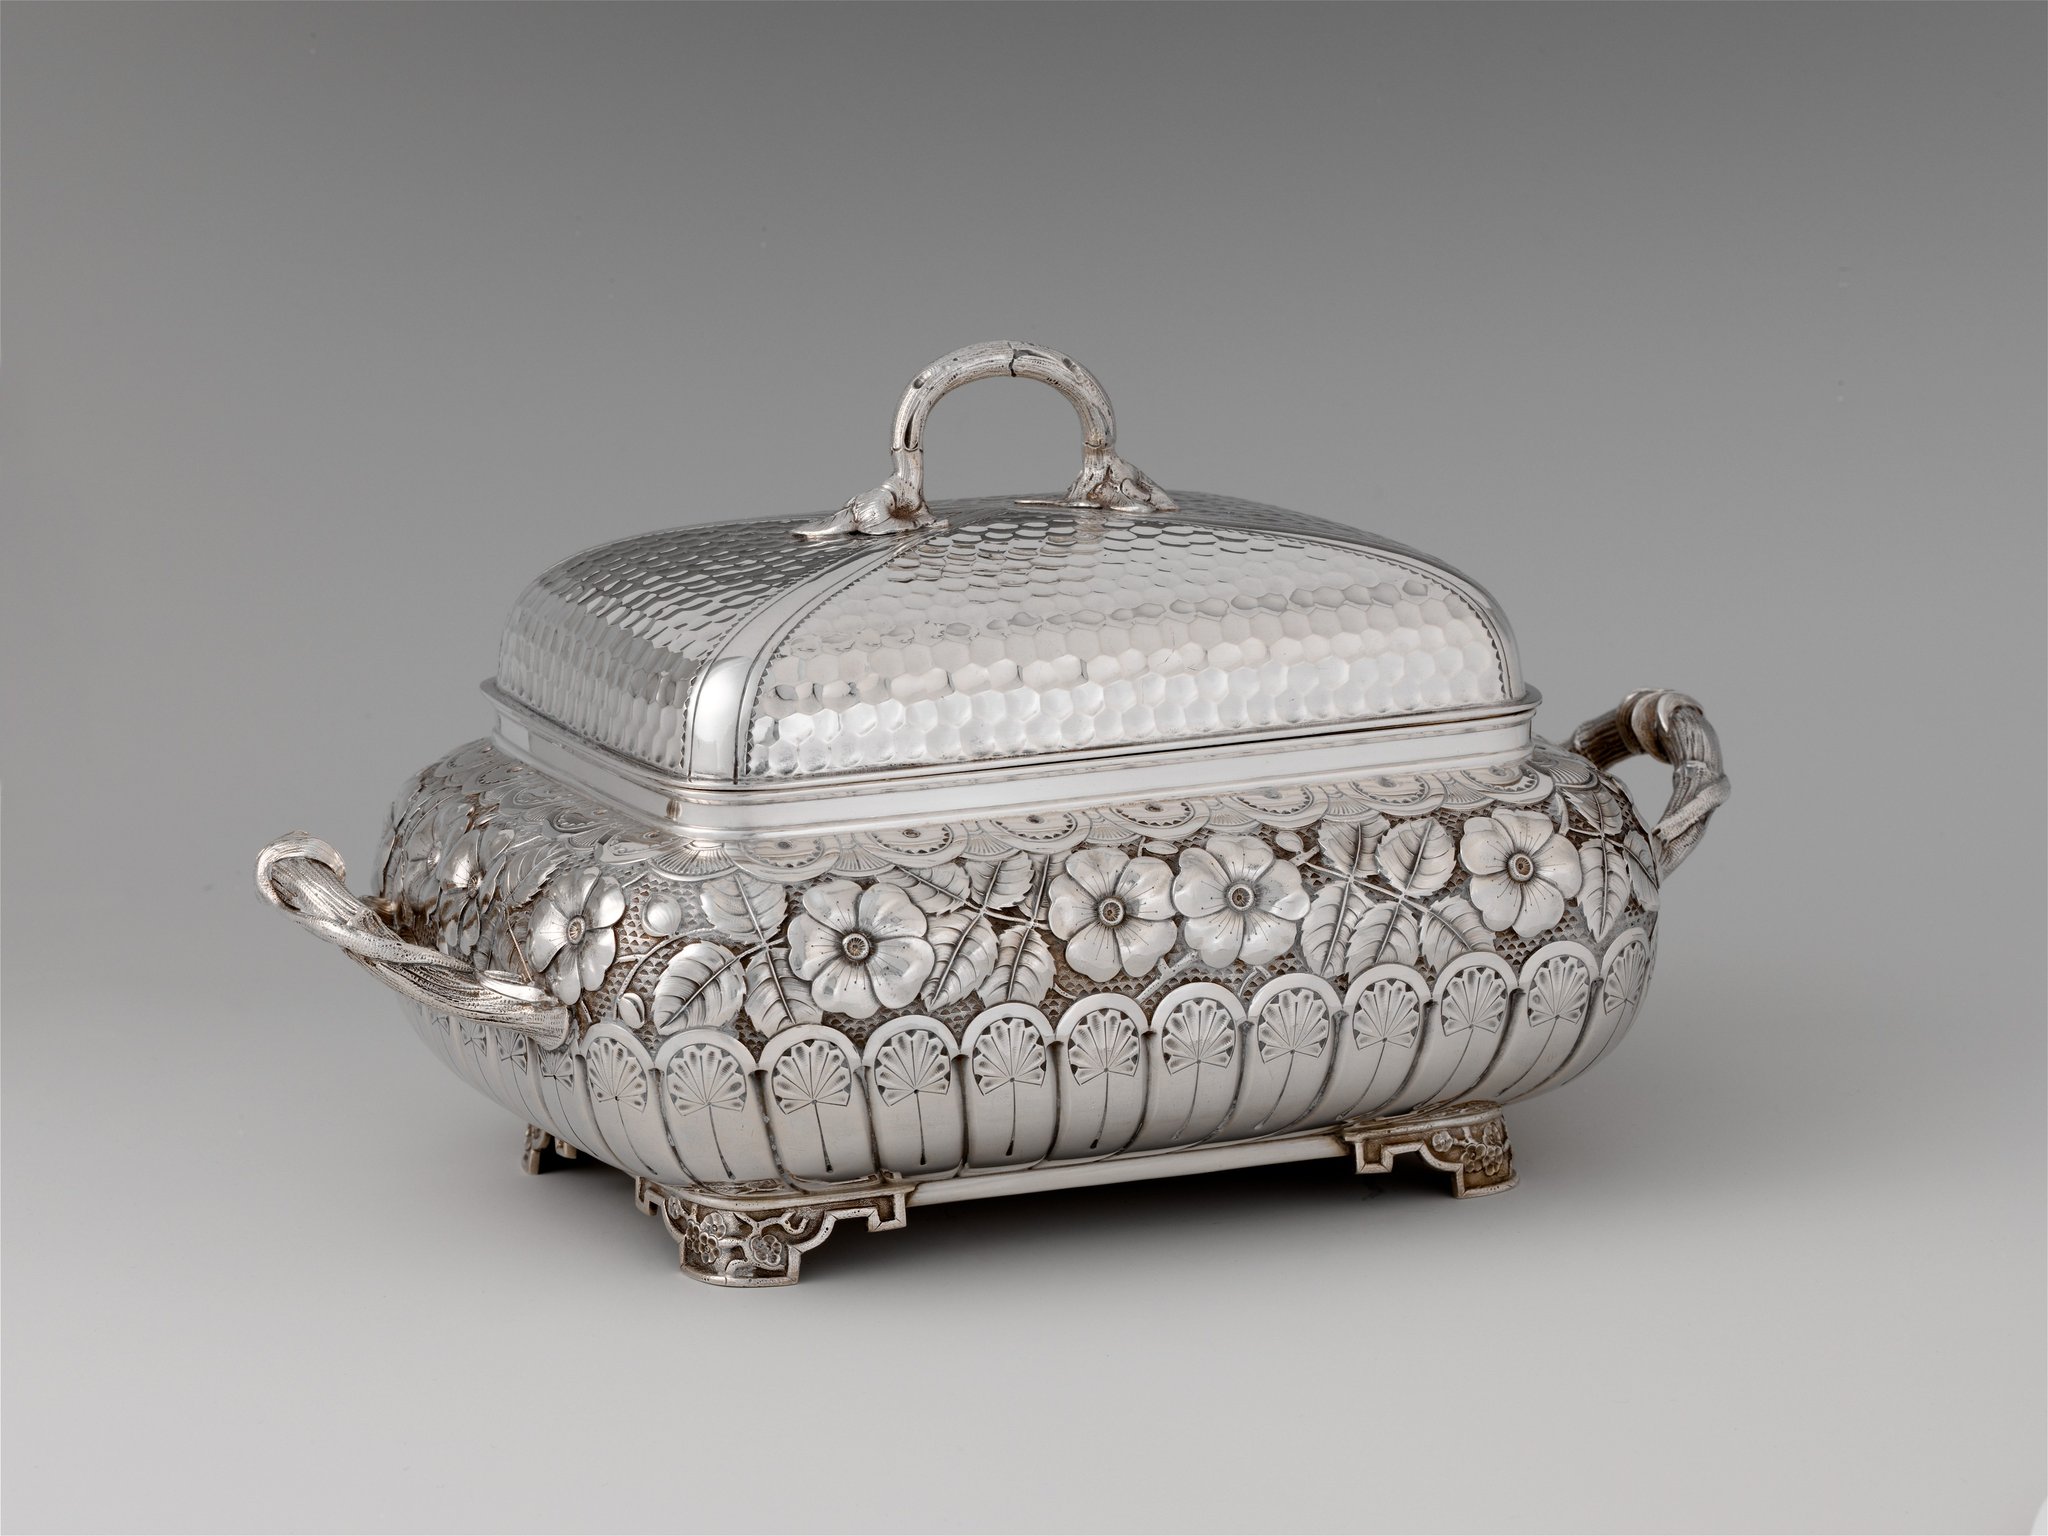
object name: dish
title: Covered Dish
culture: american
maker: john t. vansant manufacturing company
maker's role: maker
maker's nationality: american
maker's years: 1881-1892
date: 1883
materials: silver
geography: united states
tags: flowers